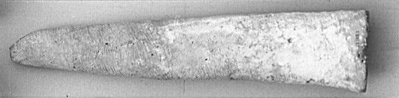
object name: cone, uninscribed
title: Funerary cone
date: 2124-1981 BCE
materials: paint, pottery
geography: egypt